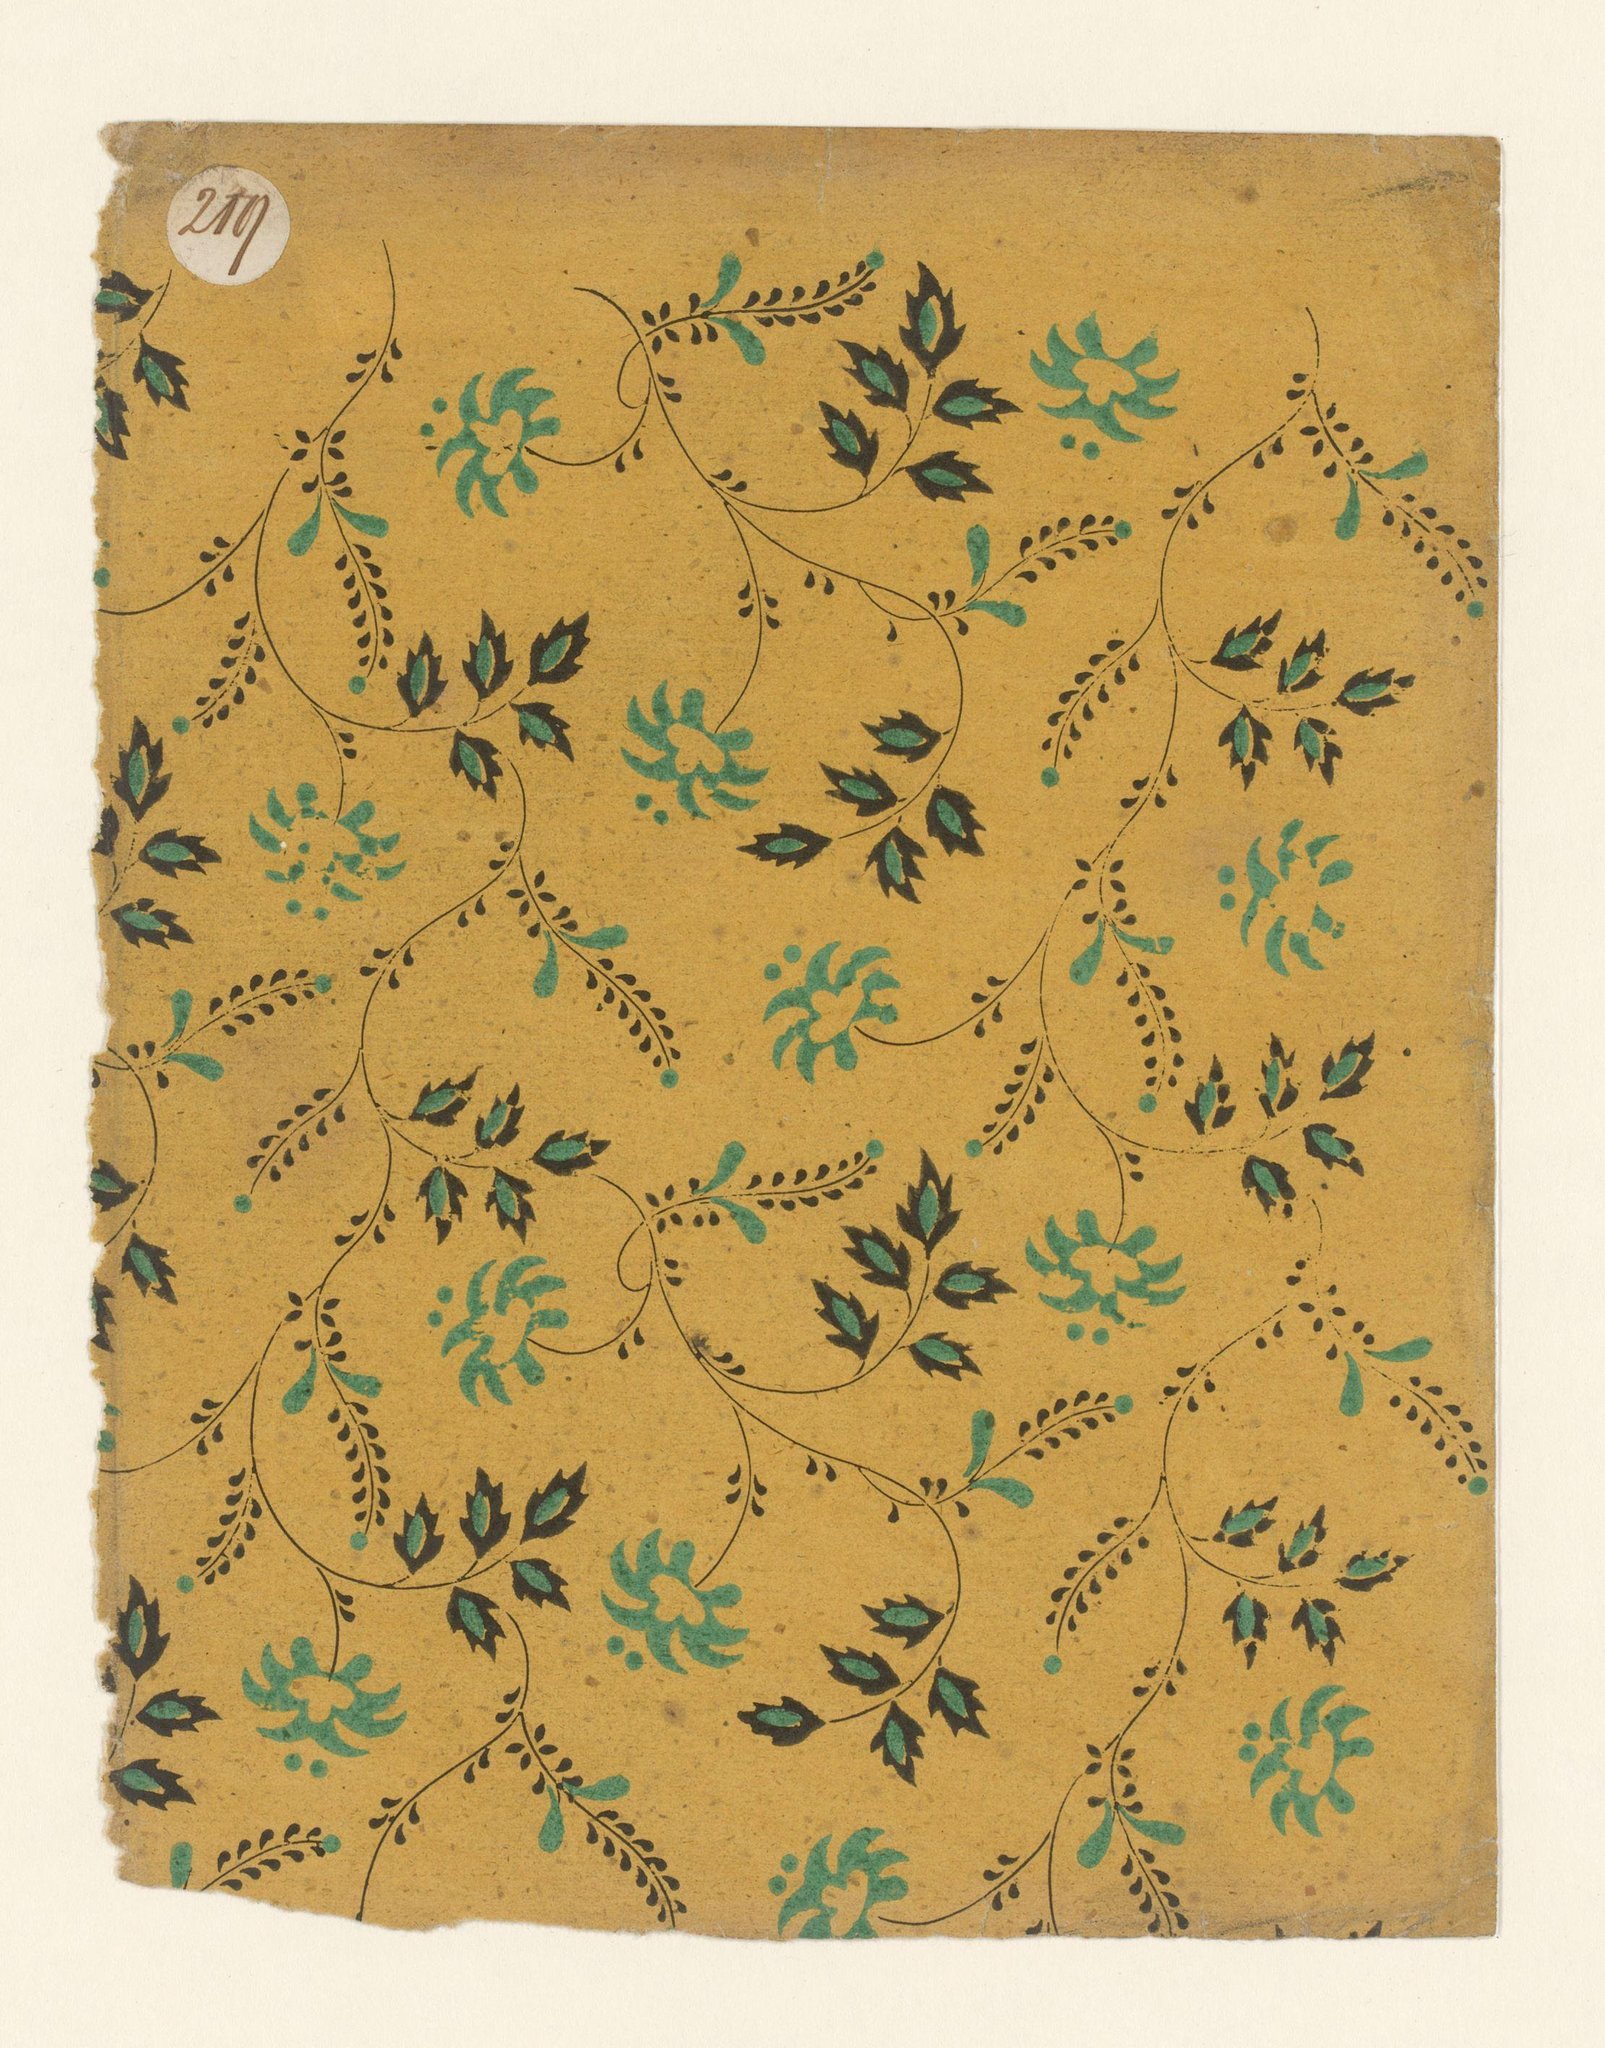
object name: wrapper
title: Blad met slingerende bladranken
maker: Anonymous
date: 1700-1850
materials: paper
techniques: printing block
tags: ornament derived from plant forms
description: Blad met patroon van slingerende bladranken met bloemen. Helft van een omslag. Linksboven een etiket met '219'.